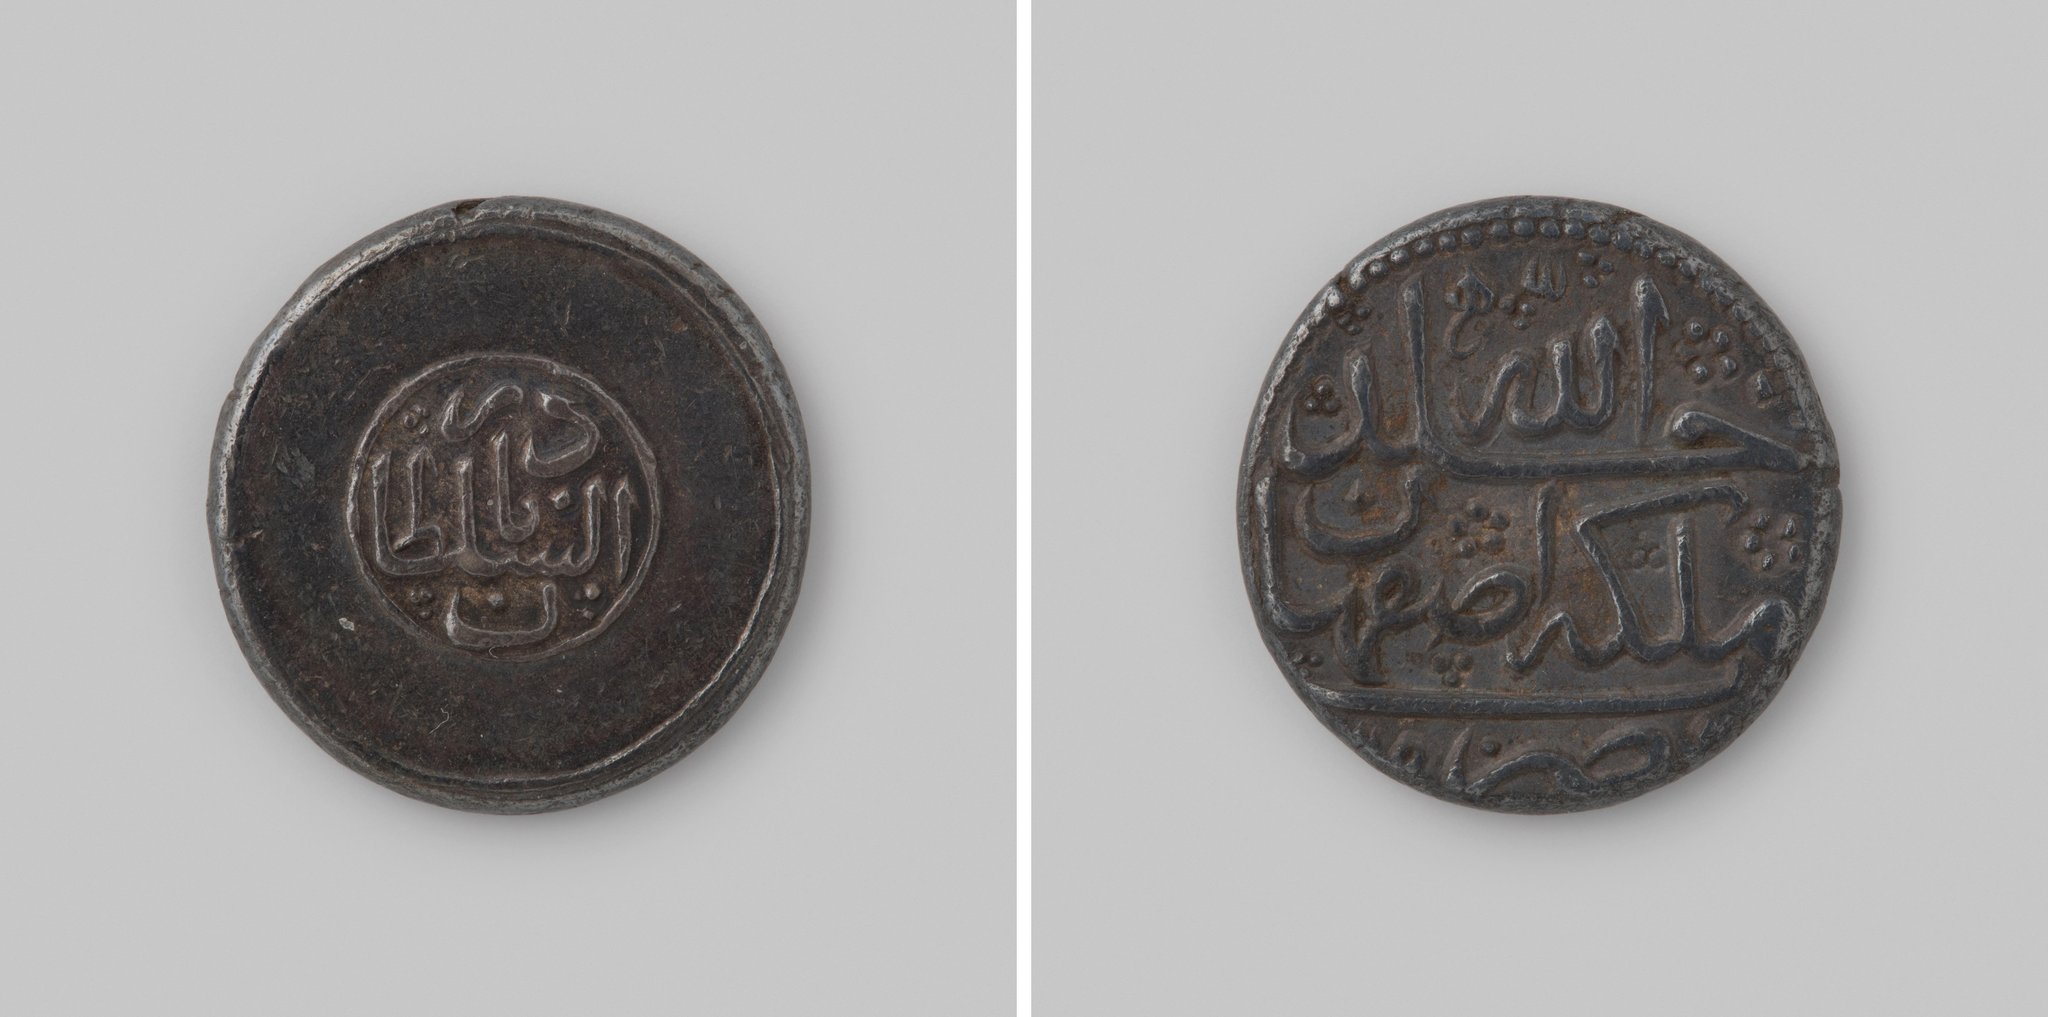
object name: coin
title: 6 shahi uit Perzië van sjah Nadir, 1148-1160 AH [=1735-1747], 115[-]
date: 1737-1746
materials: silver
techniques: striking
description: Zilveren munt. Voorzijde: binnen cirkel in drie regels opschrift: aanduiding van de sjah als sultan. Rondom cirkel brede, gladde rand. Keerzijde: in Arabische lettertekens in twee regels rijmdicht. In linker gedeelte van tweede regel muntplaats-aanduiding: Isfahan. Links onderaan jaartel, gedeeltelijk leesbaar: 115, laatste cijfer, onder 5, niet op muntplaatje terecht gekomen. Geslagen te Isfahan. Gladde rand.